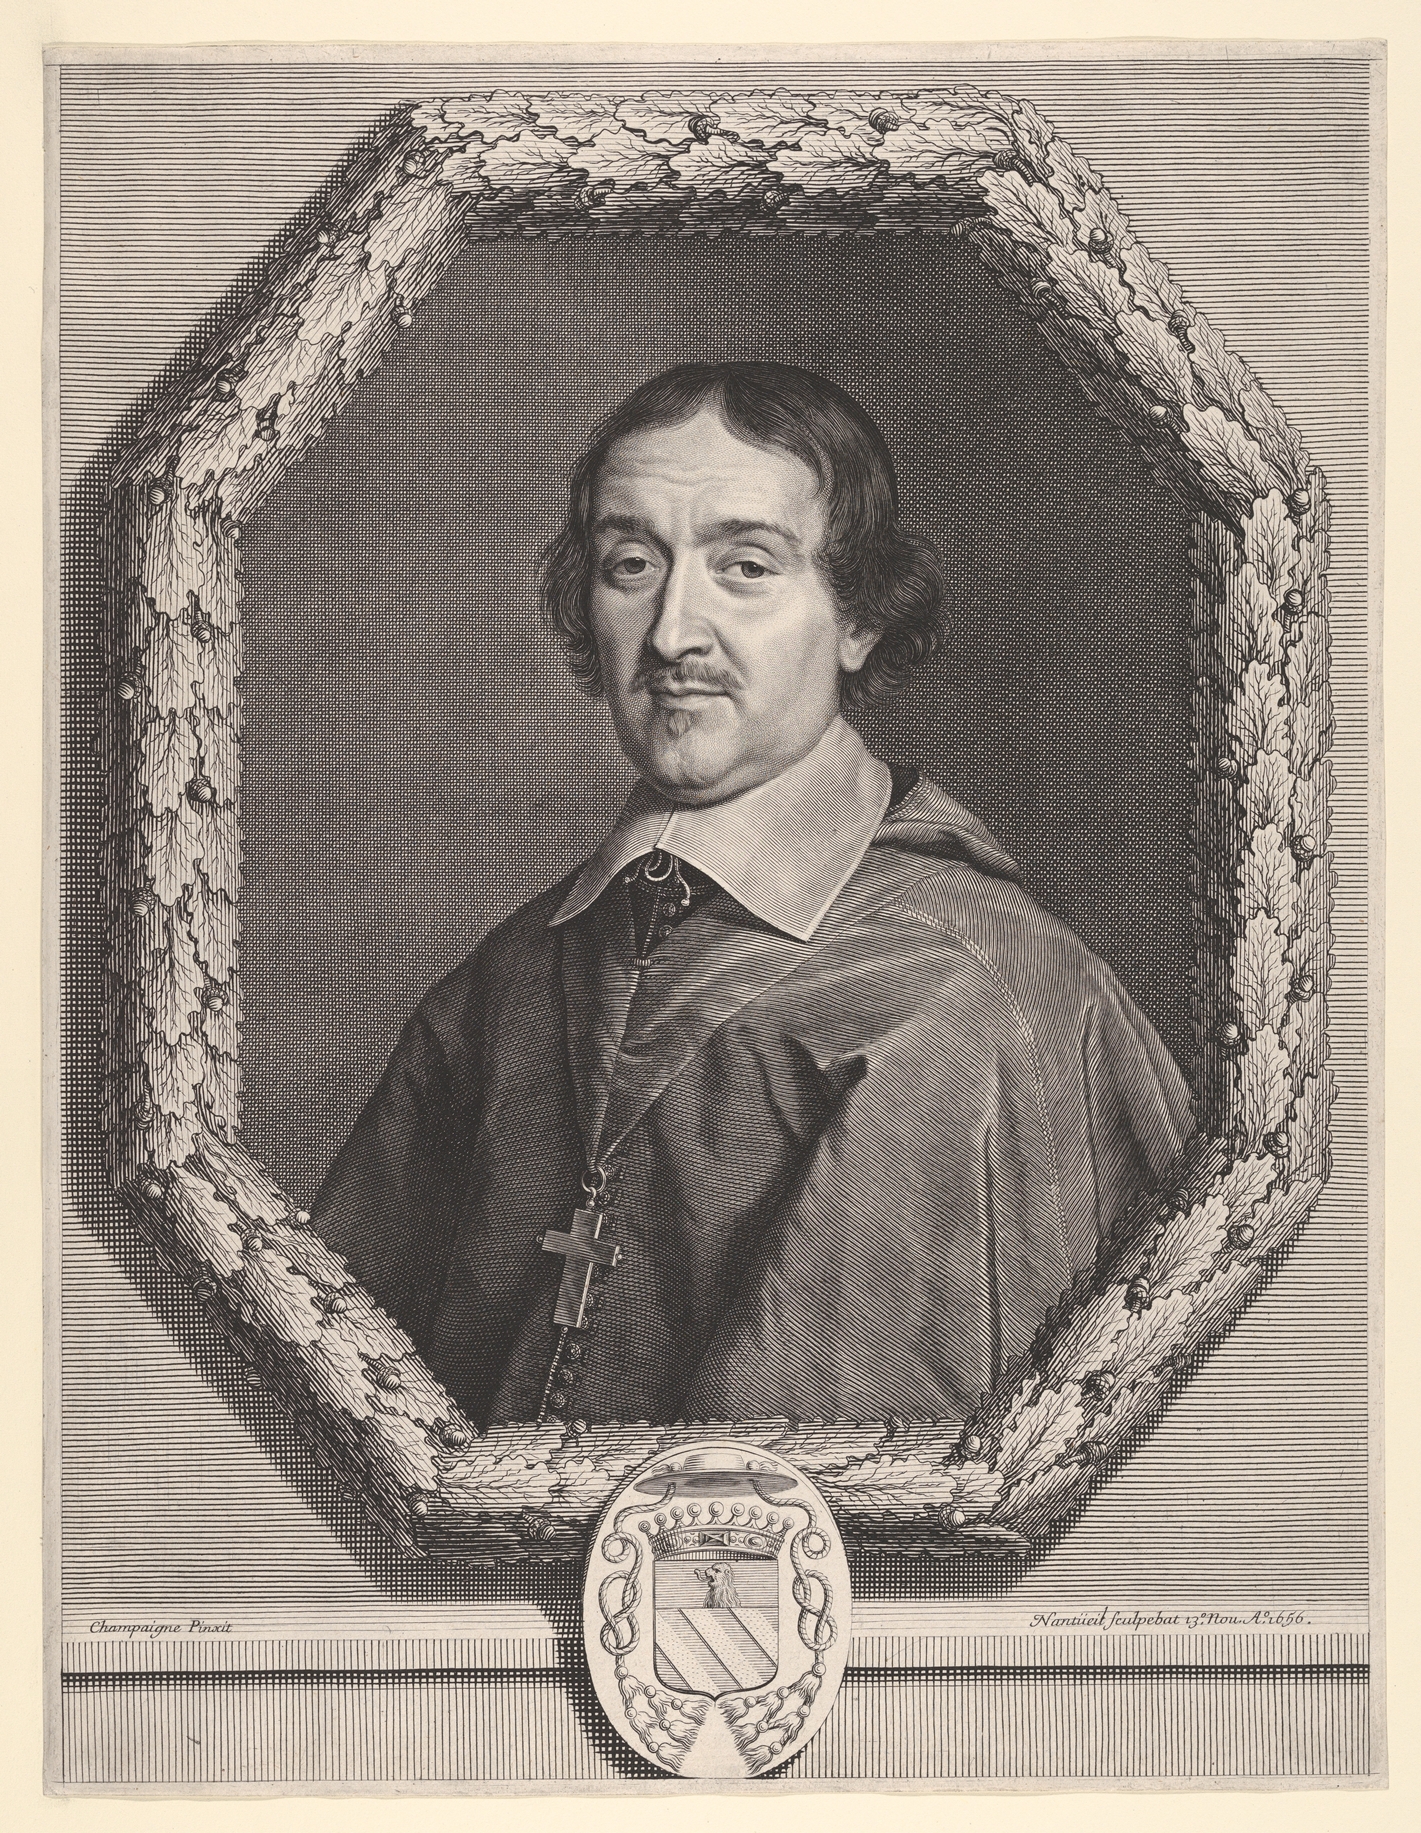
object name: print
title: François Servien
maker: robert nanteuil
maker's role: artist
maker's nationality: french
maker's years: 1623-1678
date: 1656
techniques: engraving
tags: men,portraits,coat of arms